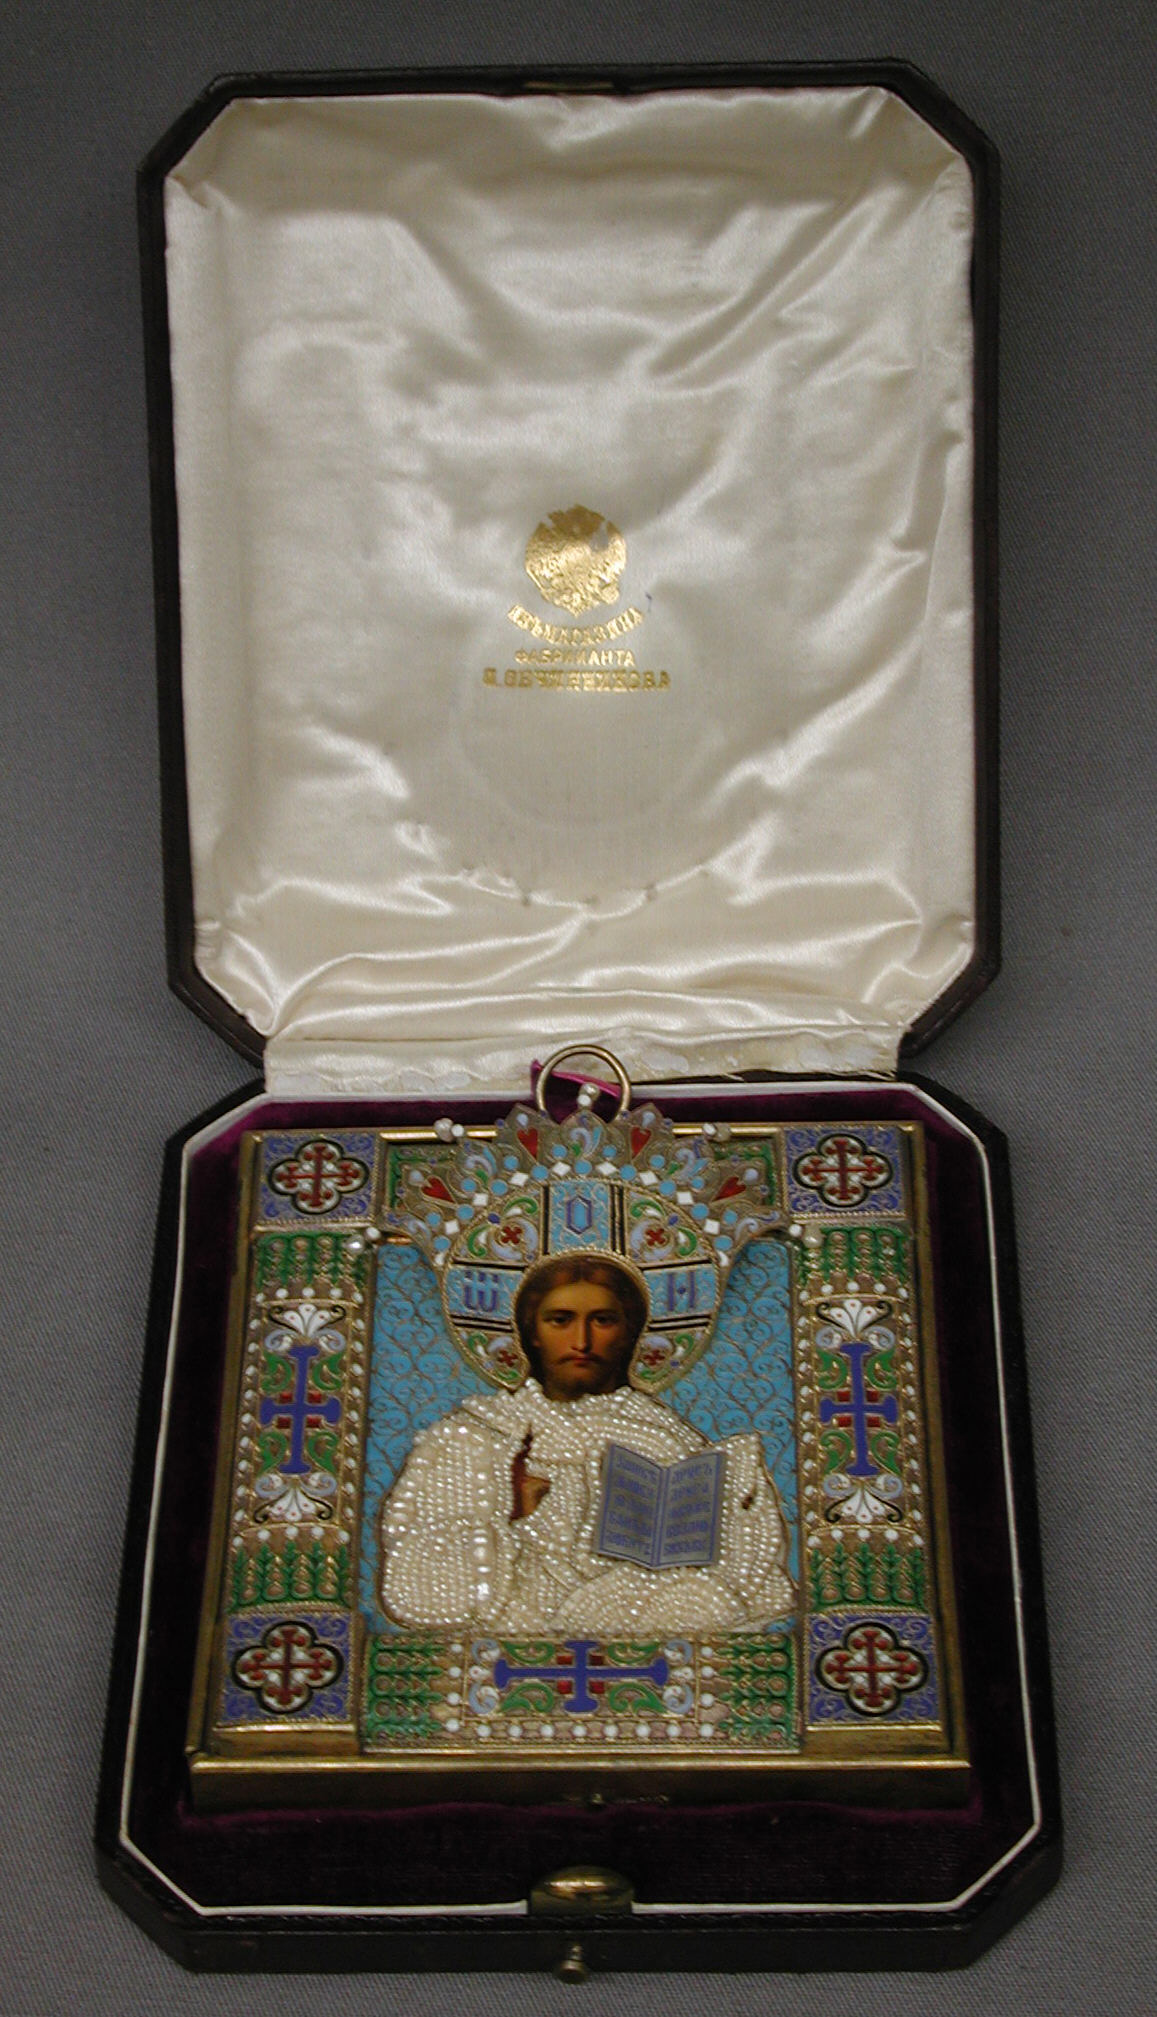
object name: icon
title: Christ Preaching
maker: russian painter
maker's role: artist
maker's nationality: russian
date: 1890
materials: enamel, gold, oil, pearl, wood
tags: christ,jesus